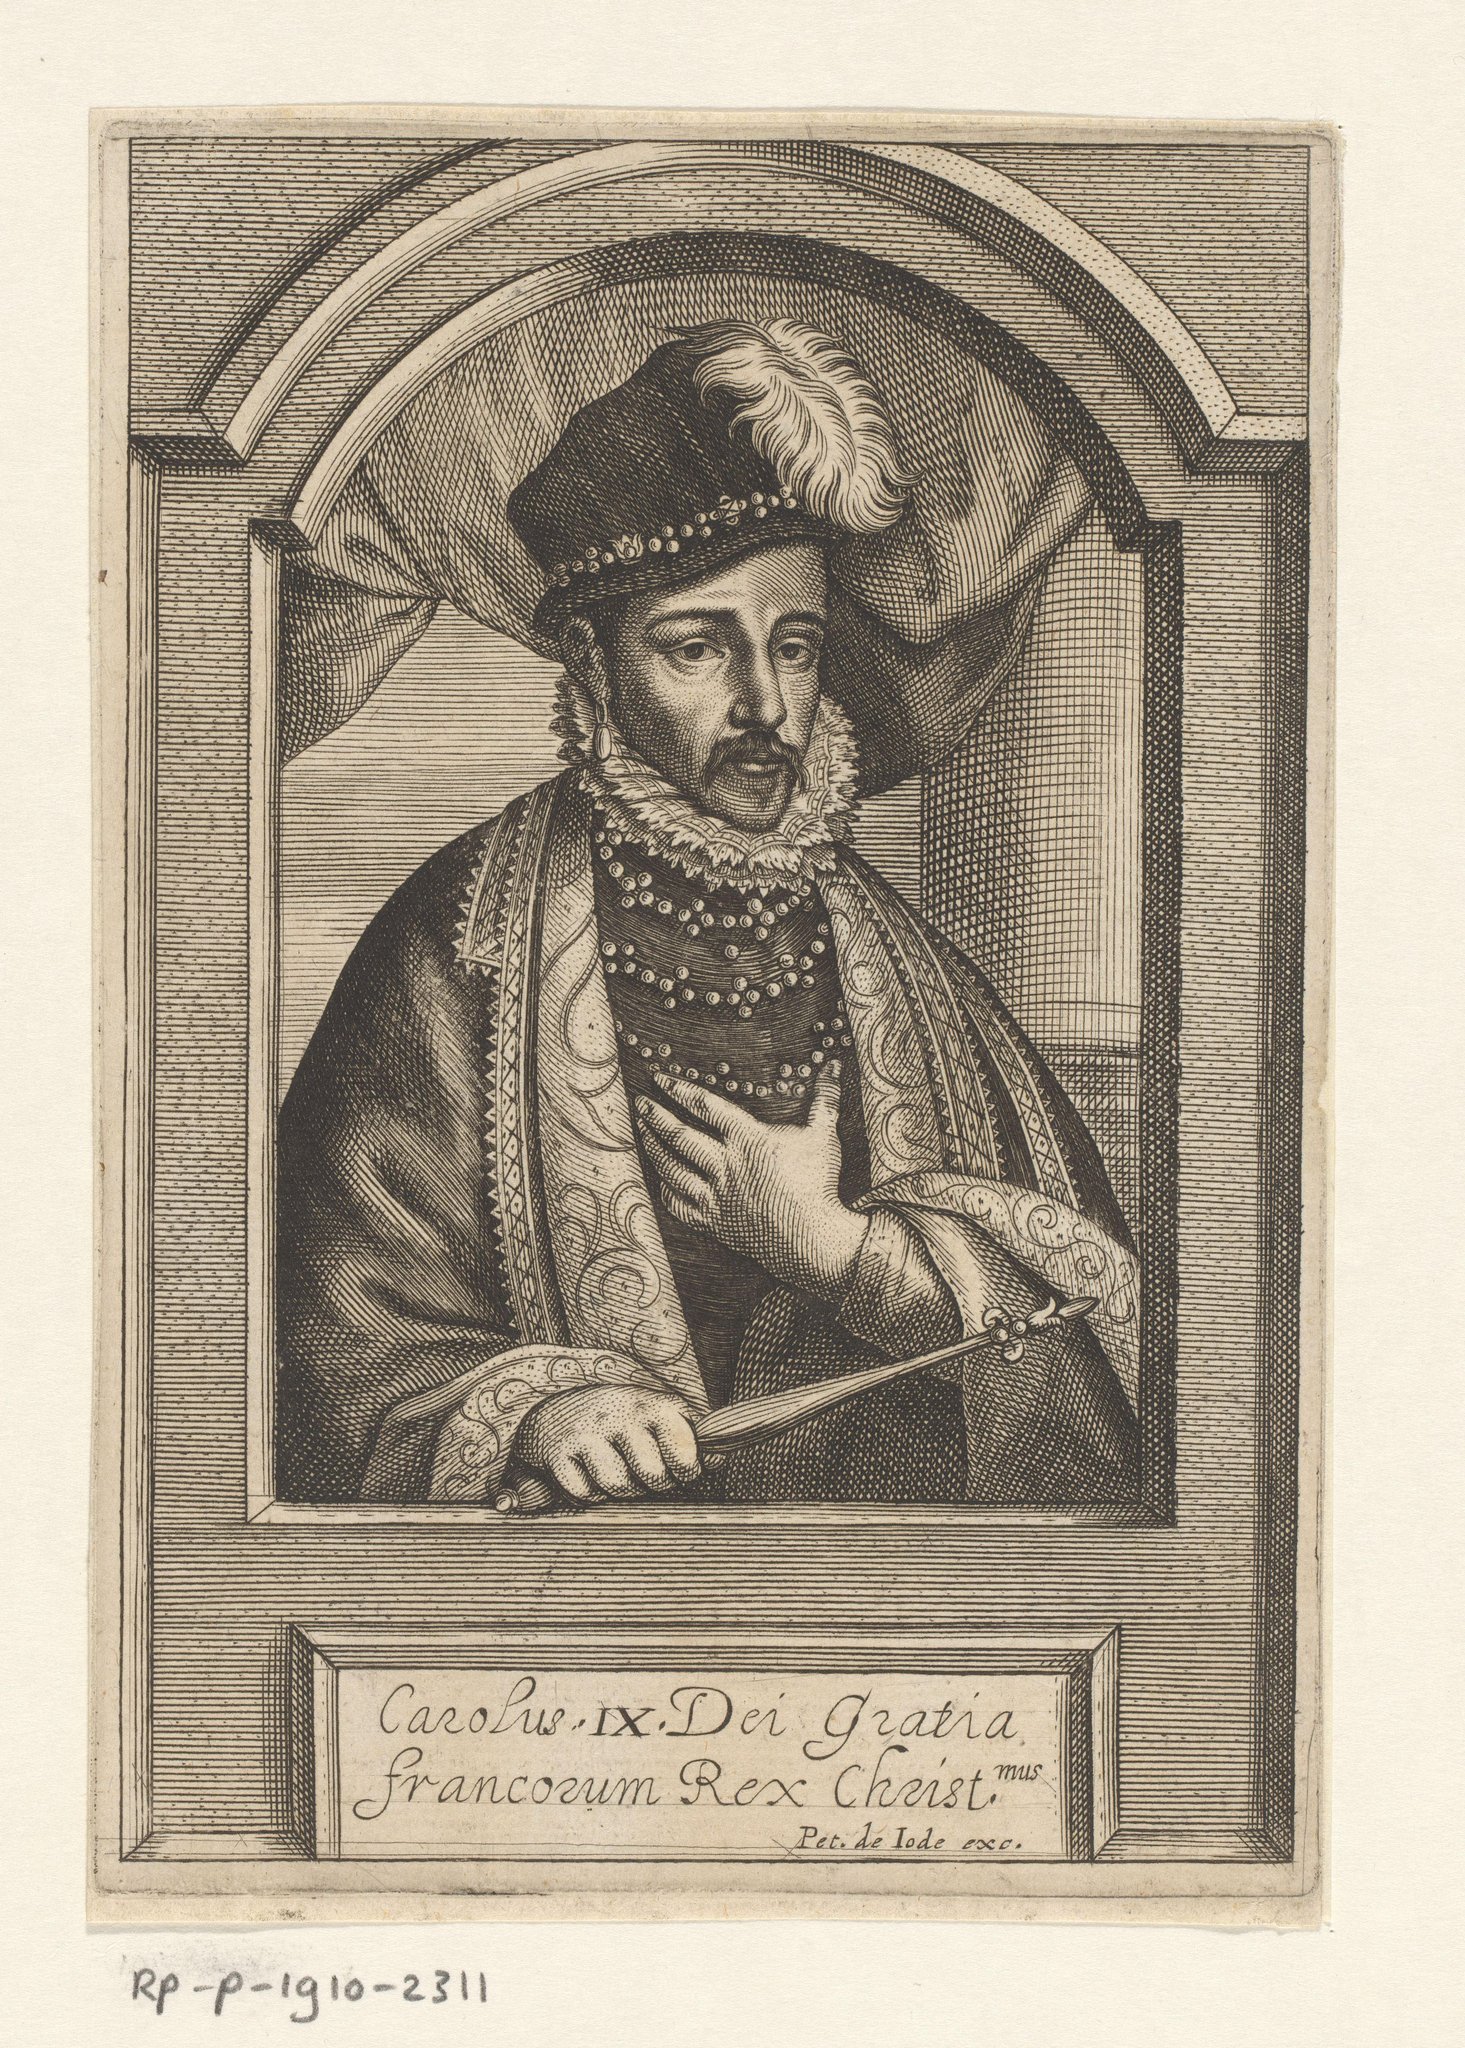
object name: print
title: Theatrum pontificum, imperatorum, regum, ducum, principum, etc.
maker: pieter de jode (ii)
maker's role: draughtsman, print maker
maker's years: 1606-1674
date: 1638-1651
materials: paper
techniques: engraving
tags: karel ix (koning van frankrijk), historical persons, king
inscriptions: collector's mark: Lugt 2228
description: De prent is gebruikt voor De Jode's serie Theater van portretten (zie New Hollstein), tussen 1638 en 1651 uitgegeven onder de titel 'Theatrum Principum, Ducum et Comitum (...)' en 'Theatrum pontificum, imperatorum, regum, ducum, principum, etc.'